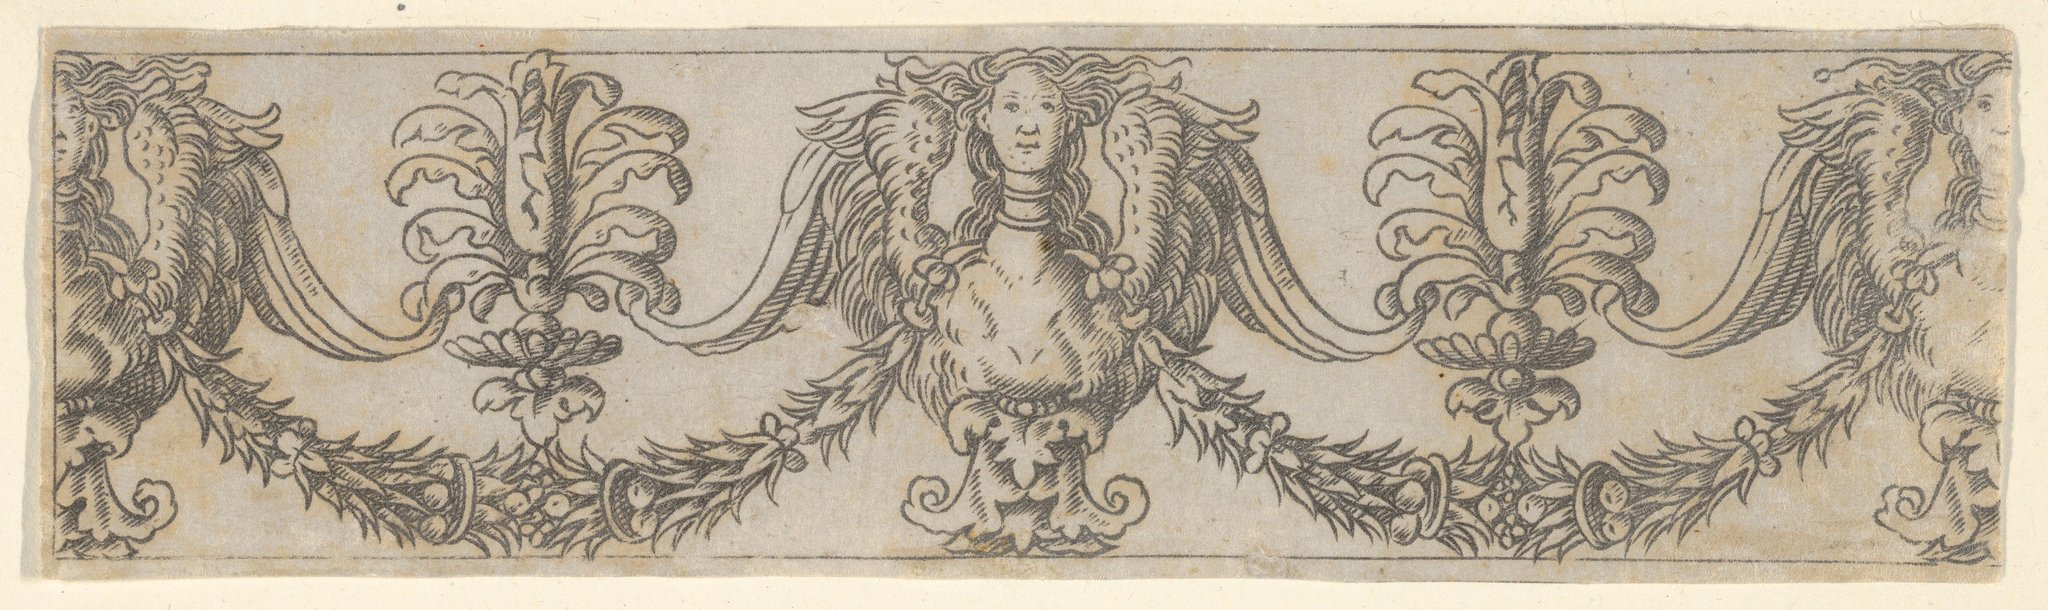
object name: print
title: Fragment of a horizontal frieze with female bust in the center, garlands, anthemia, cut from a plate of border segments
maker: francesco rosselli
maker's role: artist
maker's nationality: italian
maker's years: 1448-1527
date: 1490-1500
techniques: engraving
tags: garlands,heads